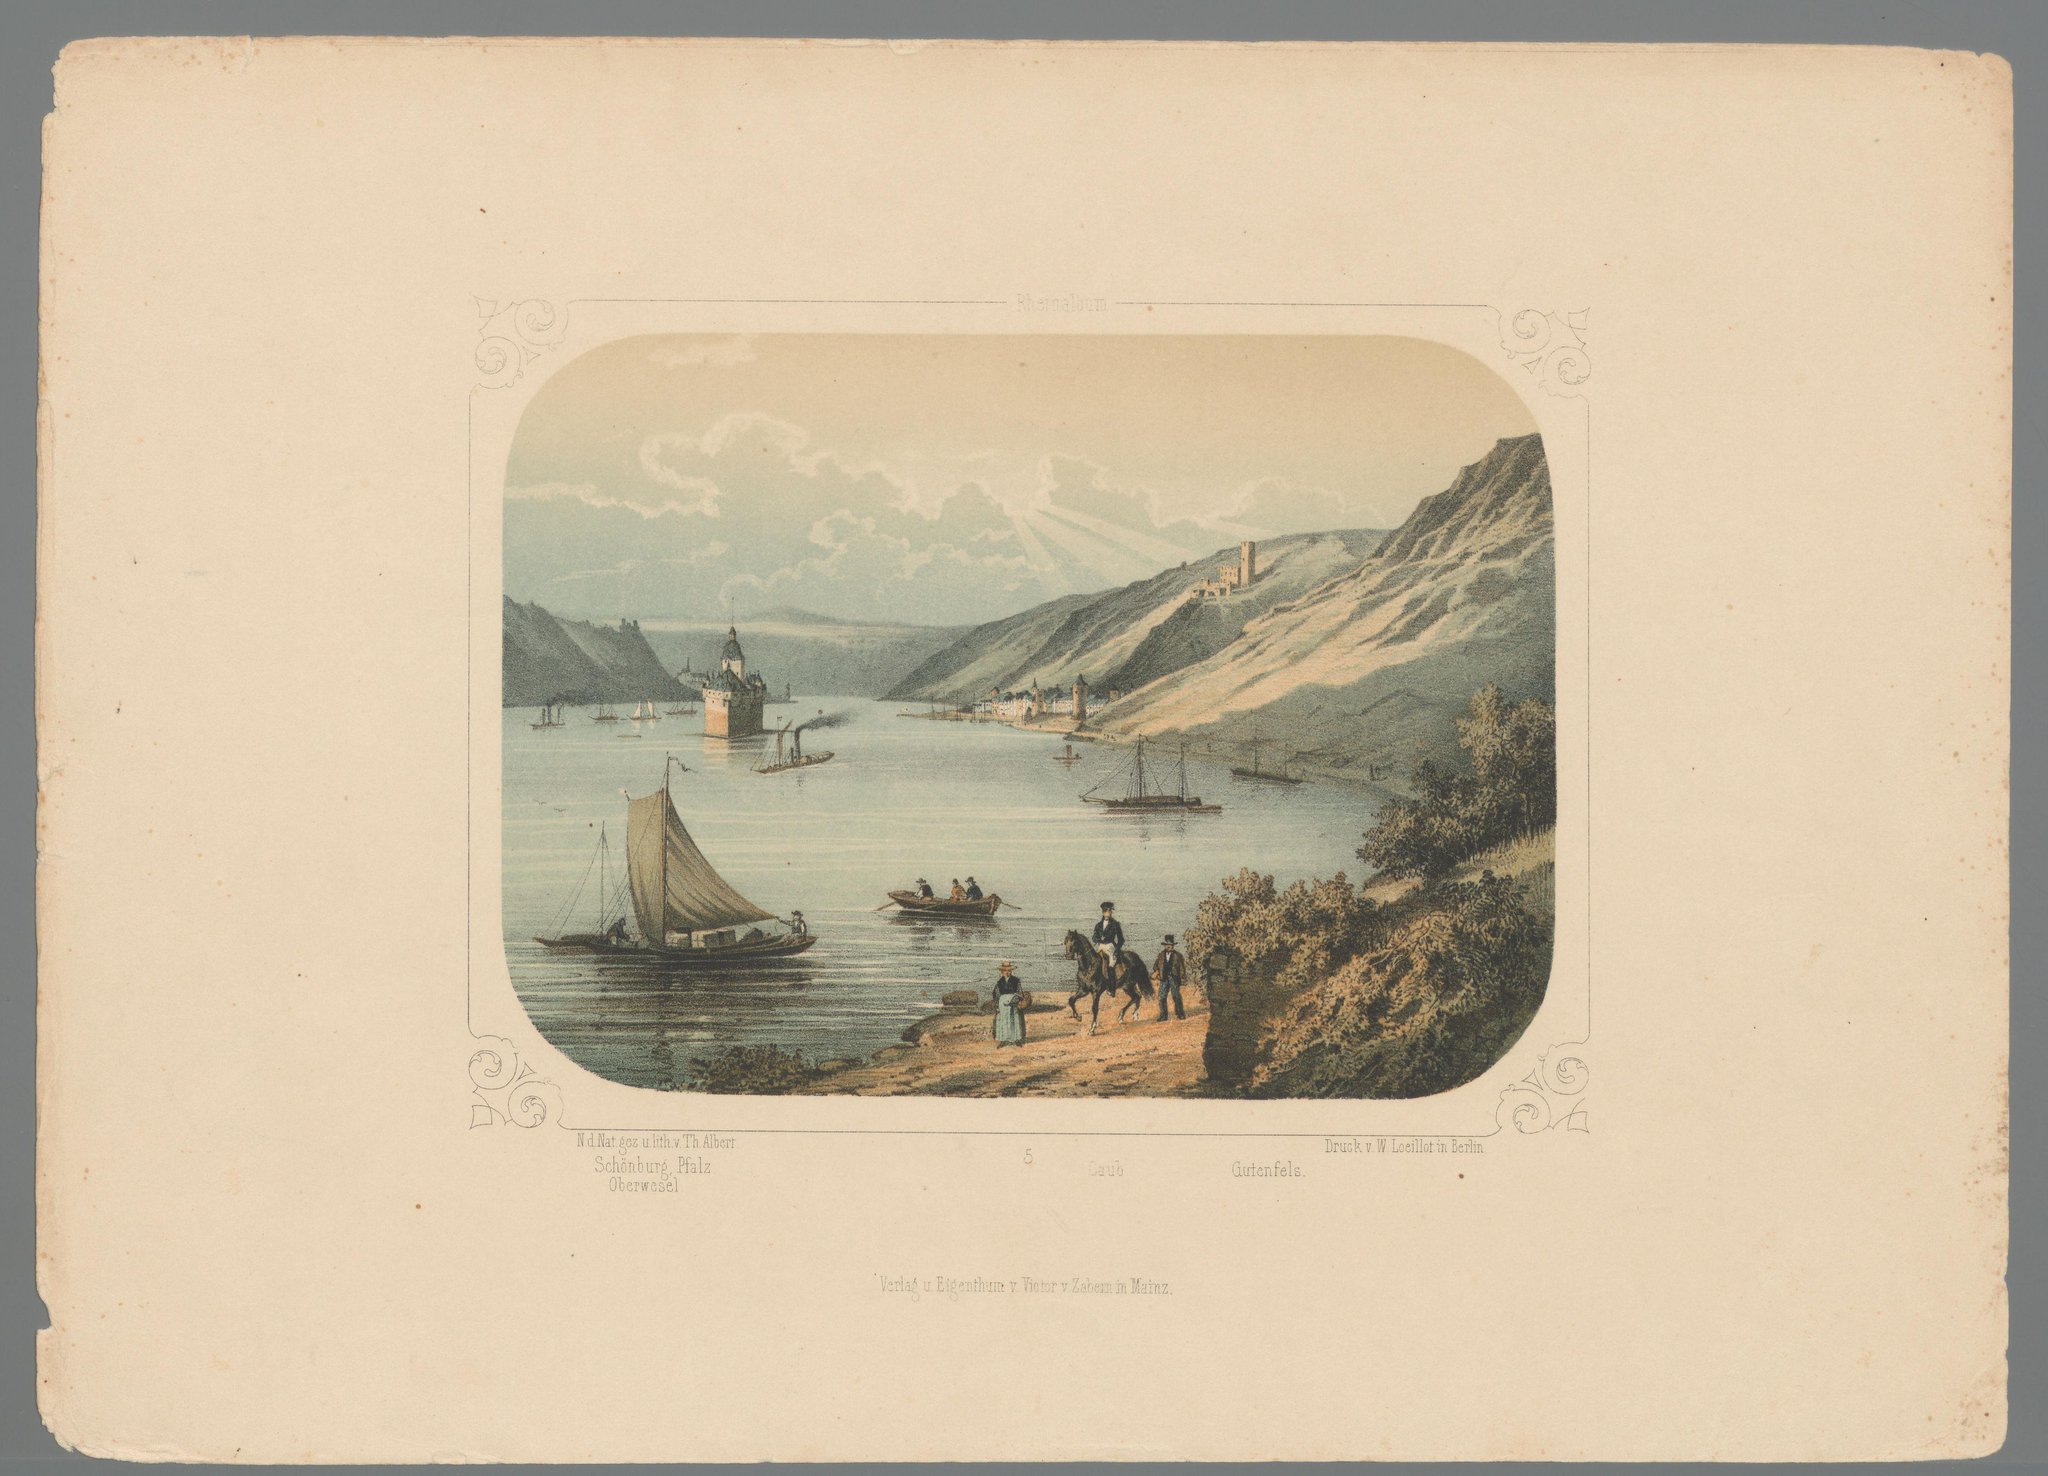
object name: print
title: Gezichten op de Rijn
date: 1858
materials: paper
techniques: lithograph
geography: mainz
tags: river, mountains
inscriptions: collector's mark: Lugt 2228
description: Prent maakt deel uit van een serie van 36 prenten, waarbij het eveneens mogelijk was deze te laten samenbinden tot een album.